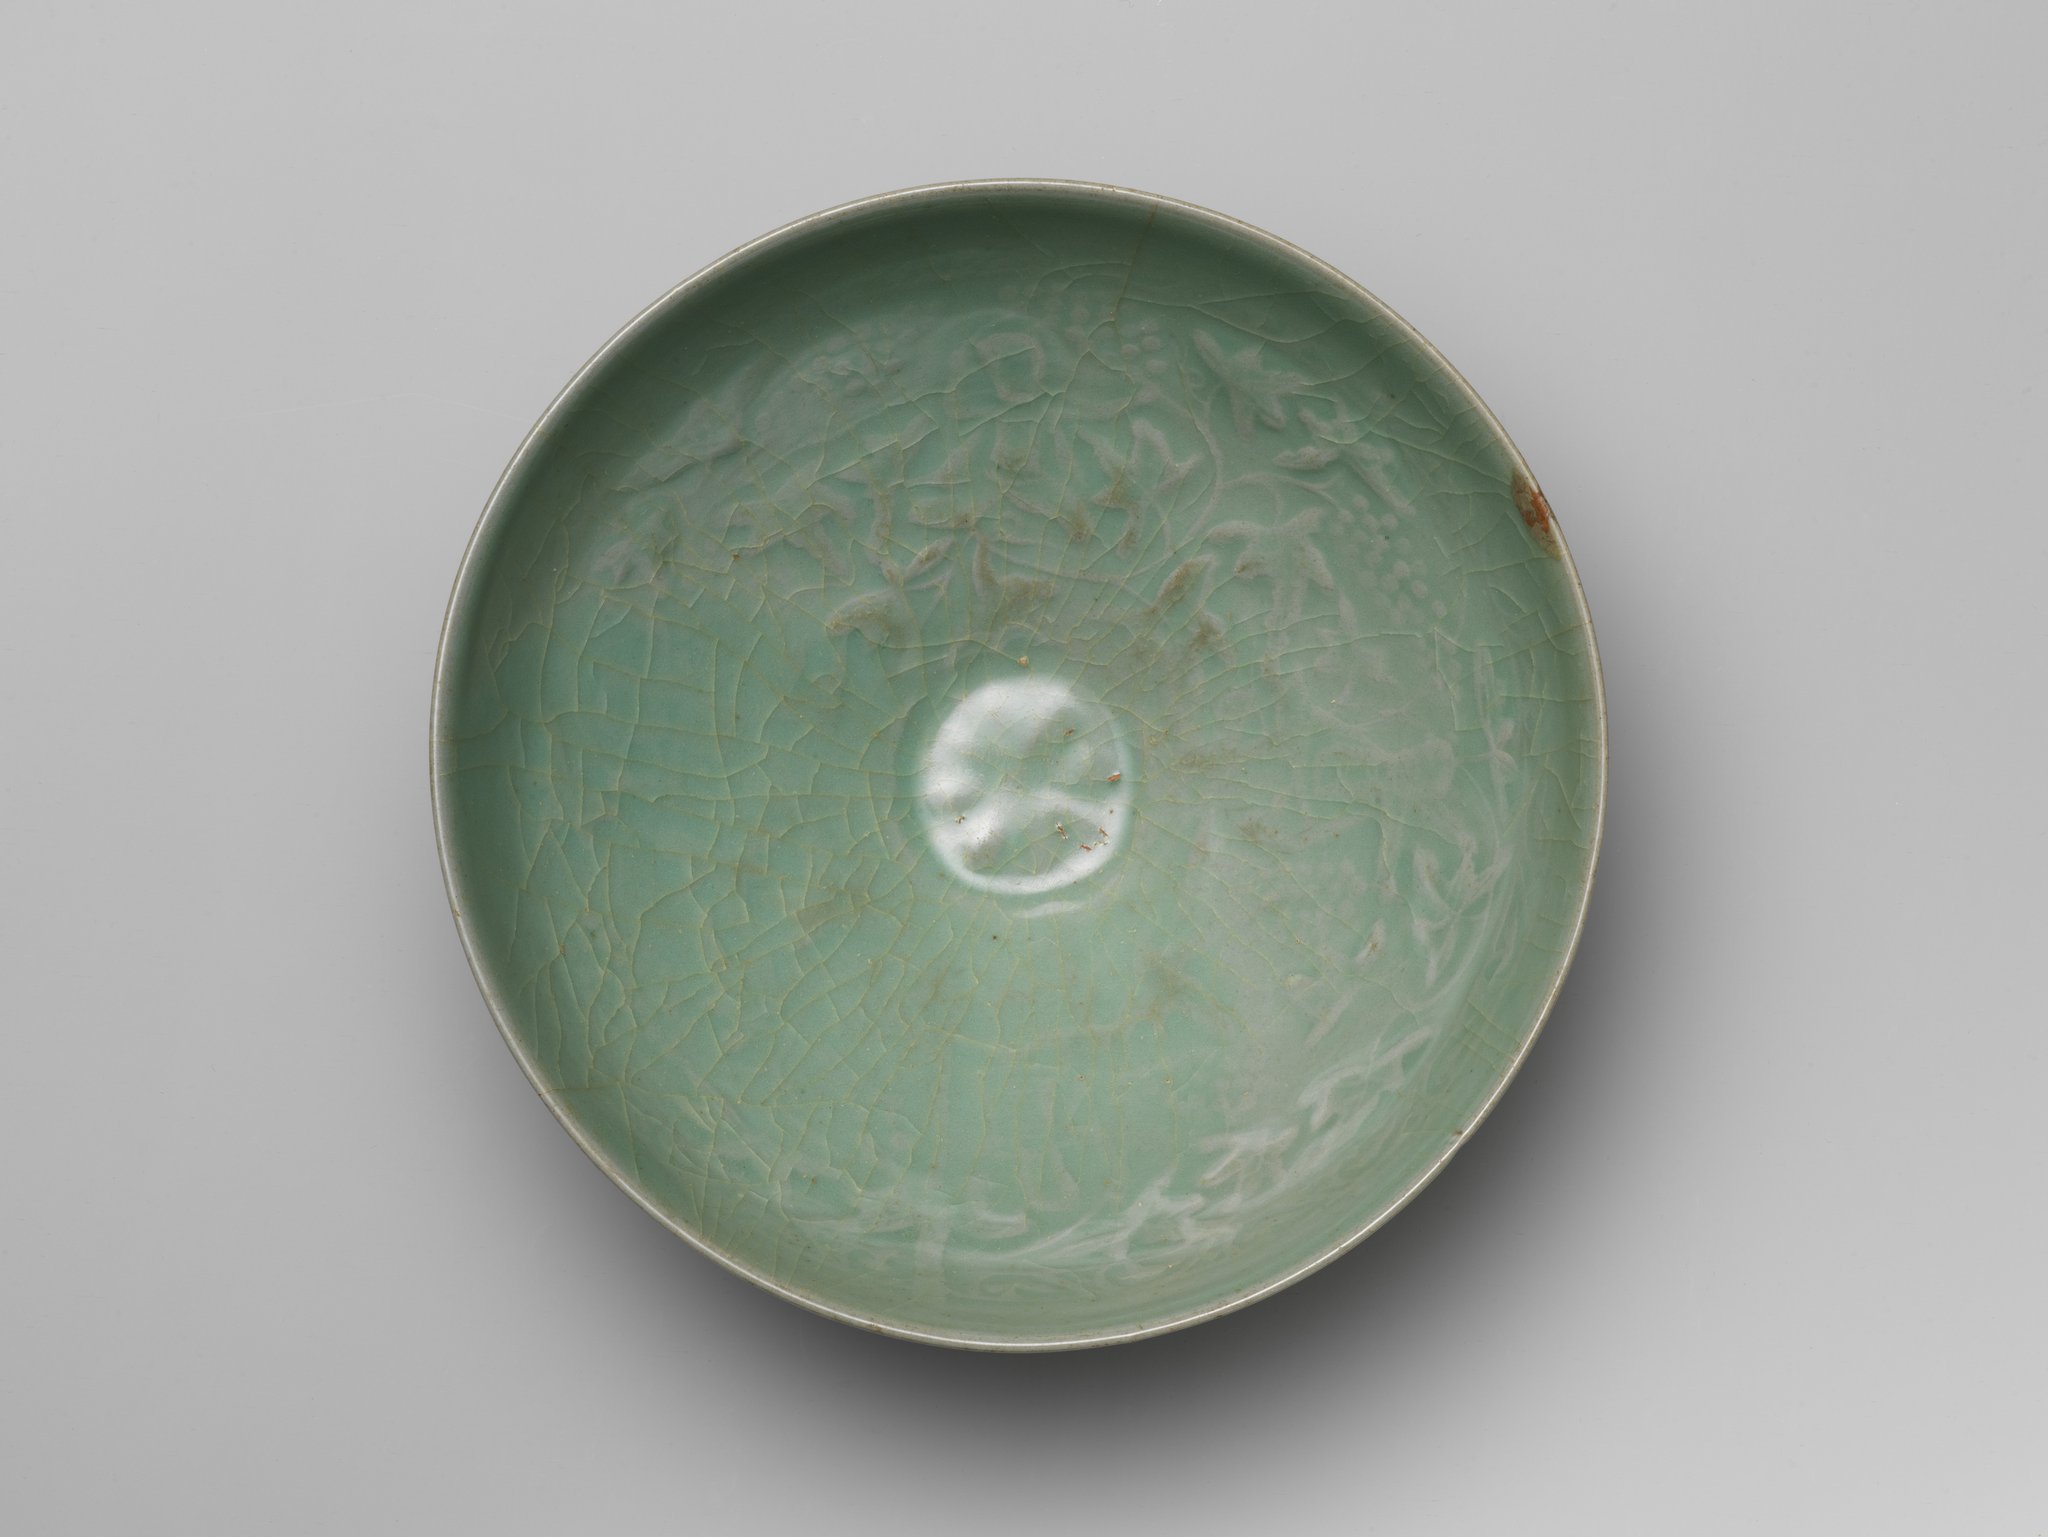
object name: bowl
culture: korean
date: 1101-1200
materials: ceramic glaze, glaze, stoneware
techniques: inlay